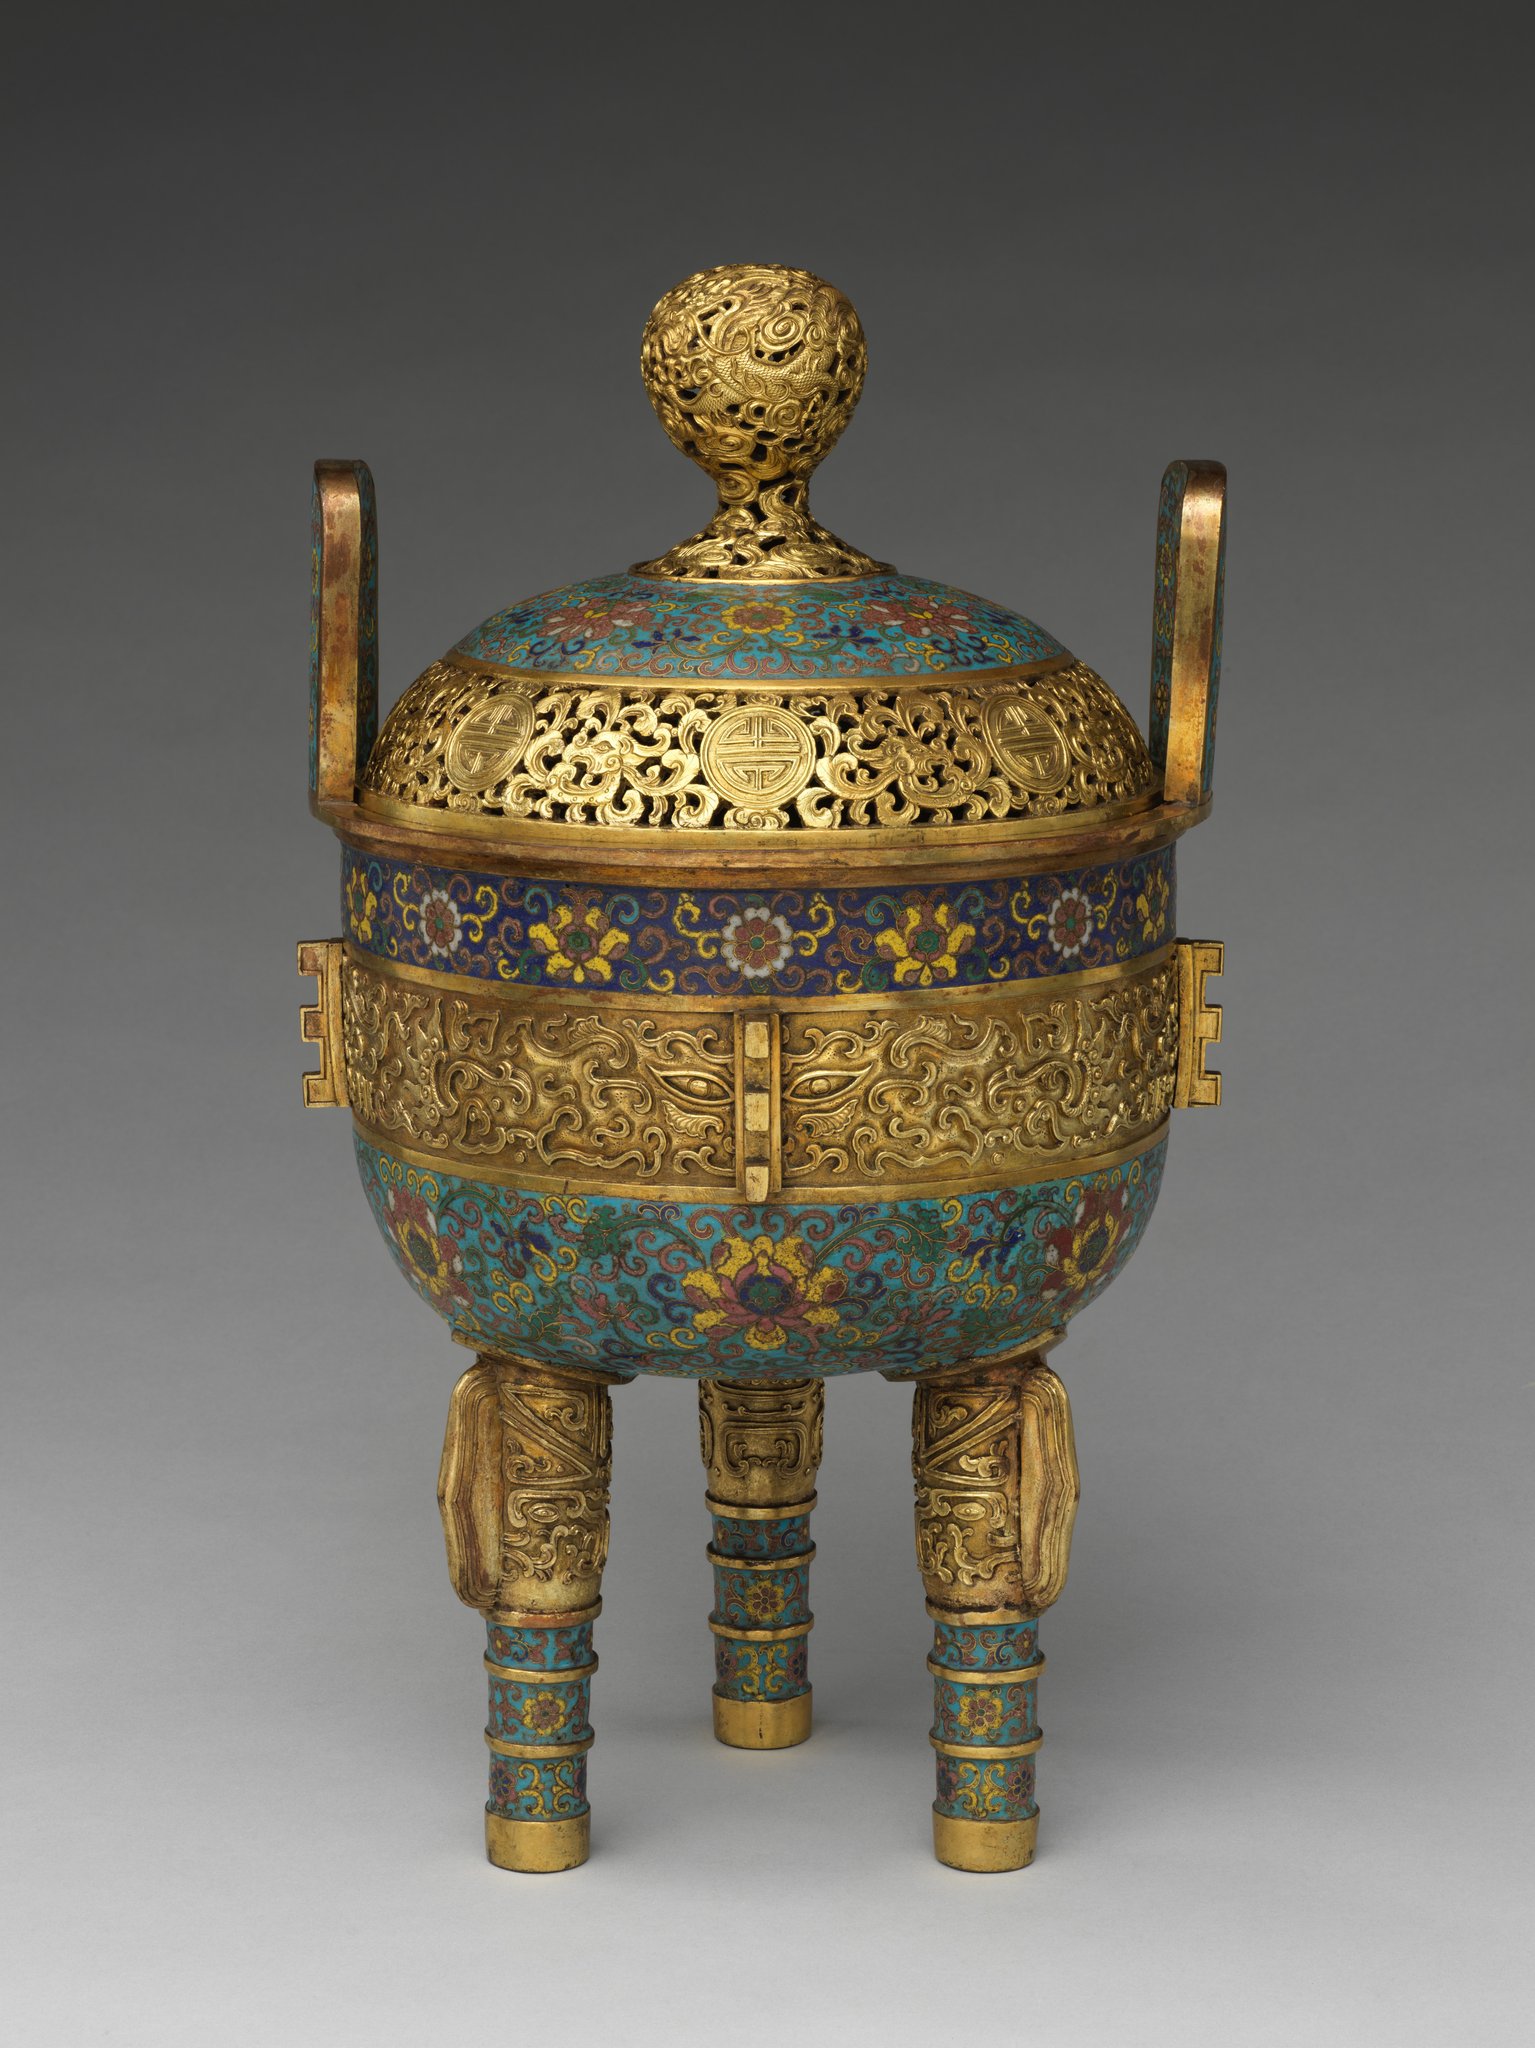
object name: incense burner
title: Tripod incense burner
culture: chinese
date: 1736-1795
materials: copper alloy, enamel, gilt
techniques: enamel